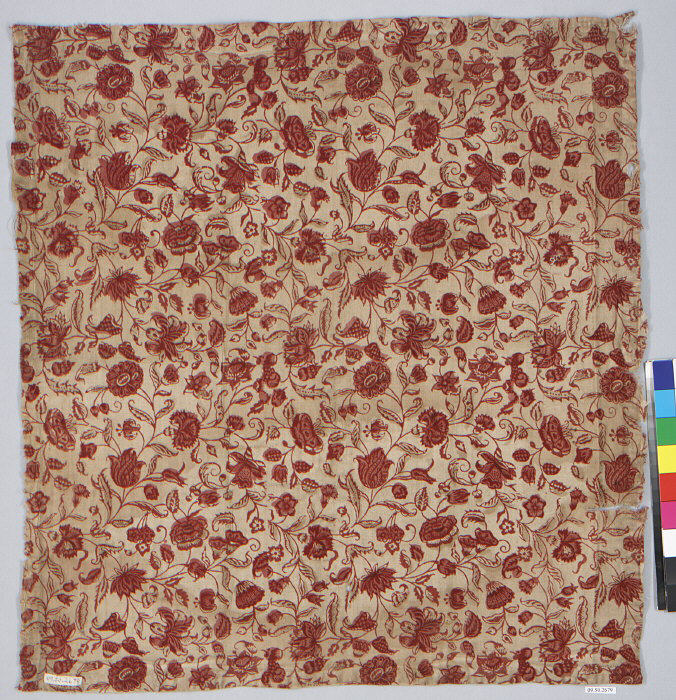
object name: fragment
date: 1734-1766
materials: linen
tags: flowers,leaves